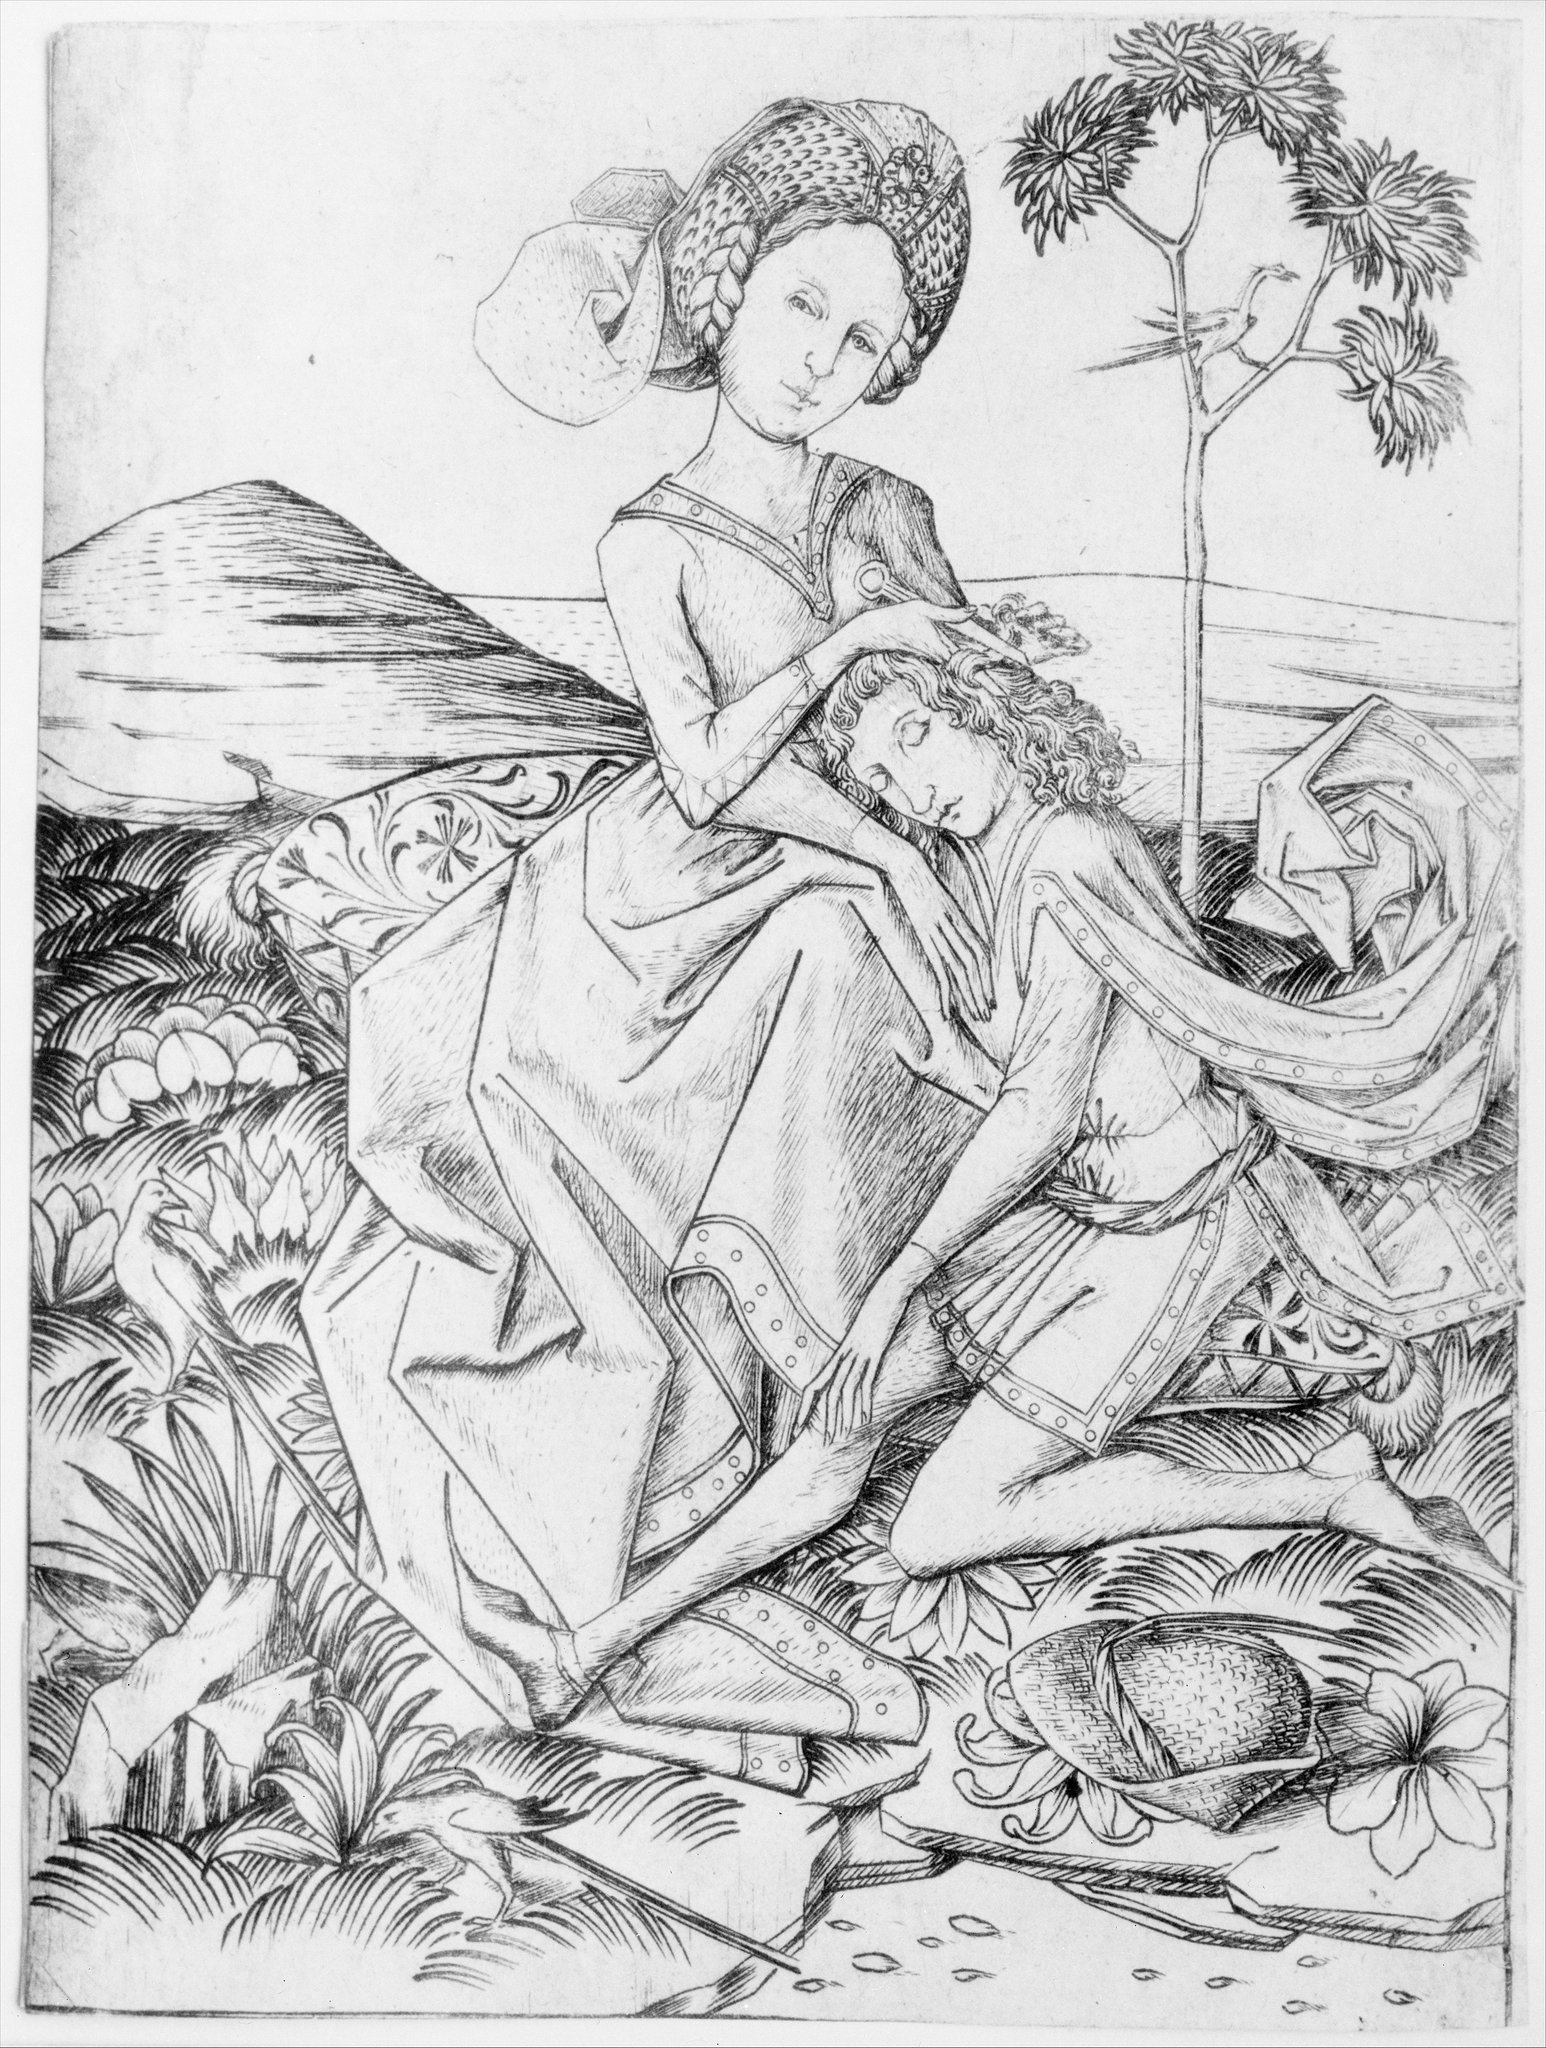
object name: print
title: Samson and Delilah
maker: master es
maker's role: artist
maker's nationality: german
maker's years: 1445-1467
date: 1401-1500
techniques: engraving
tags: men,women